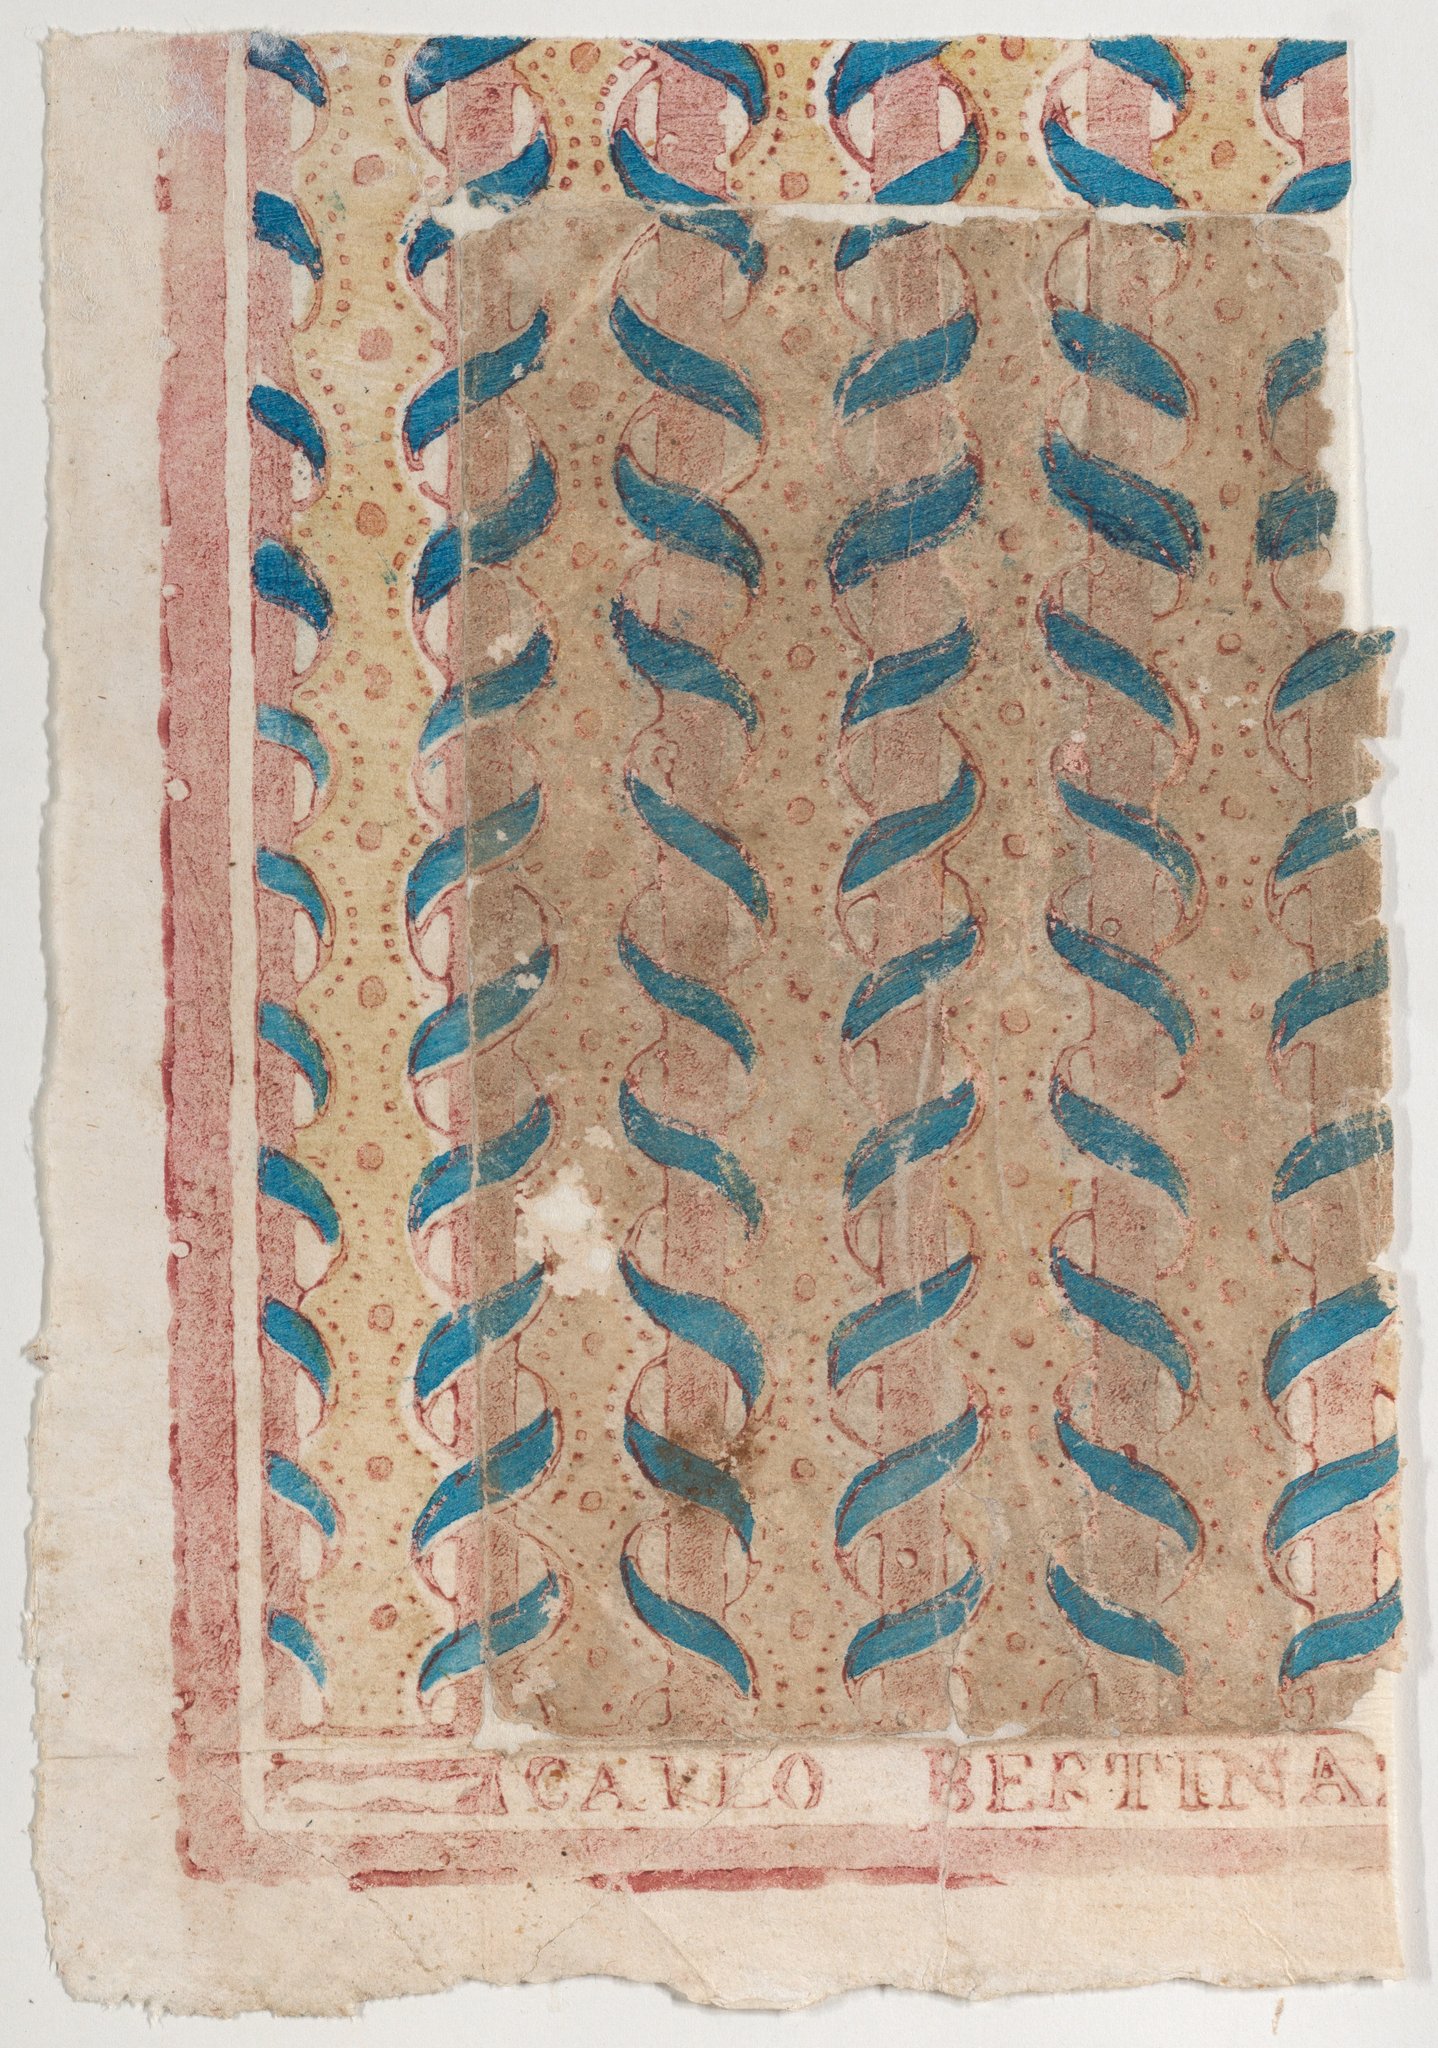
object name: print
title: Sheet with blue and pink abstract pattern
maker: Anonymous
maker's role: artist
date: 1701-1800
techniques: relief print